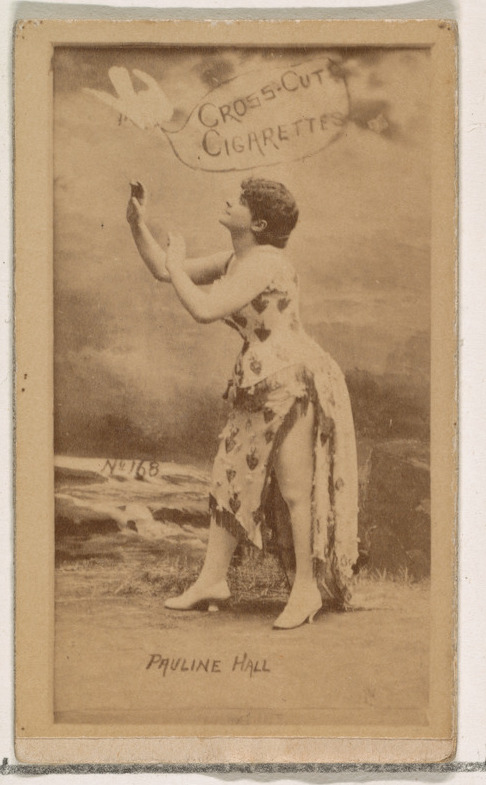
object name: print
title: Card Number 168, Pauline Hall, from the Actors and Actresses series (N145-1) issued by Duke Sons & Co. to promote Cross Cut Cigarettes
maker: w. duke, sons & co.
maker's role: publisher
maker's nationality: american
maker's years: 1870-1920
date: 1880-1889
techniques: albumen silver print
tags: portraits,women,actresses